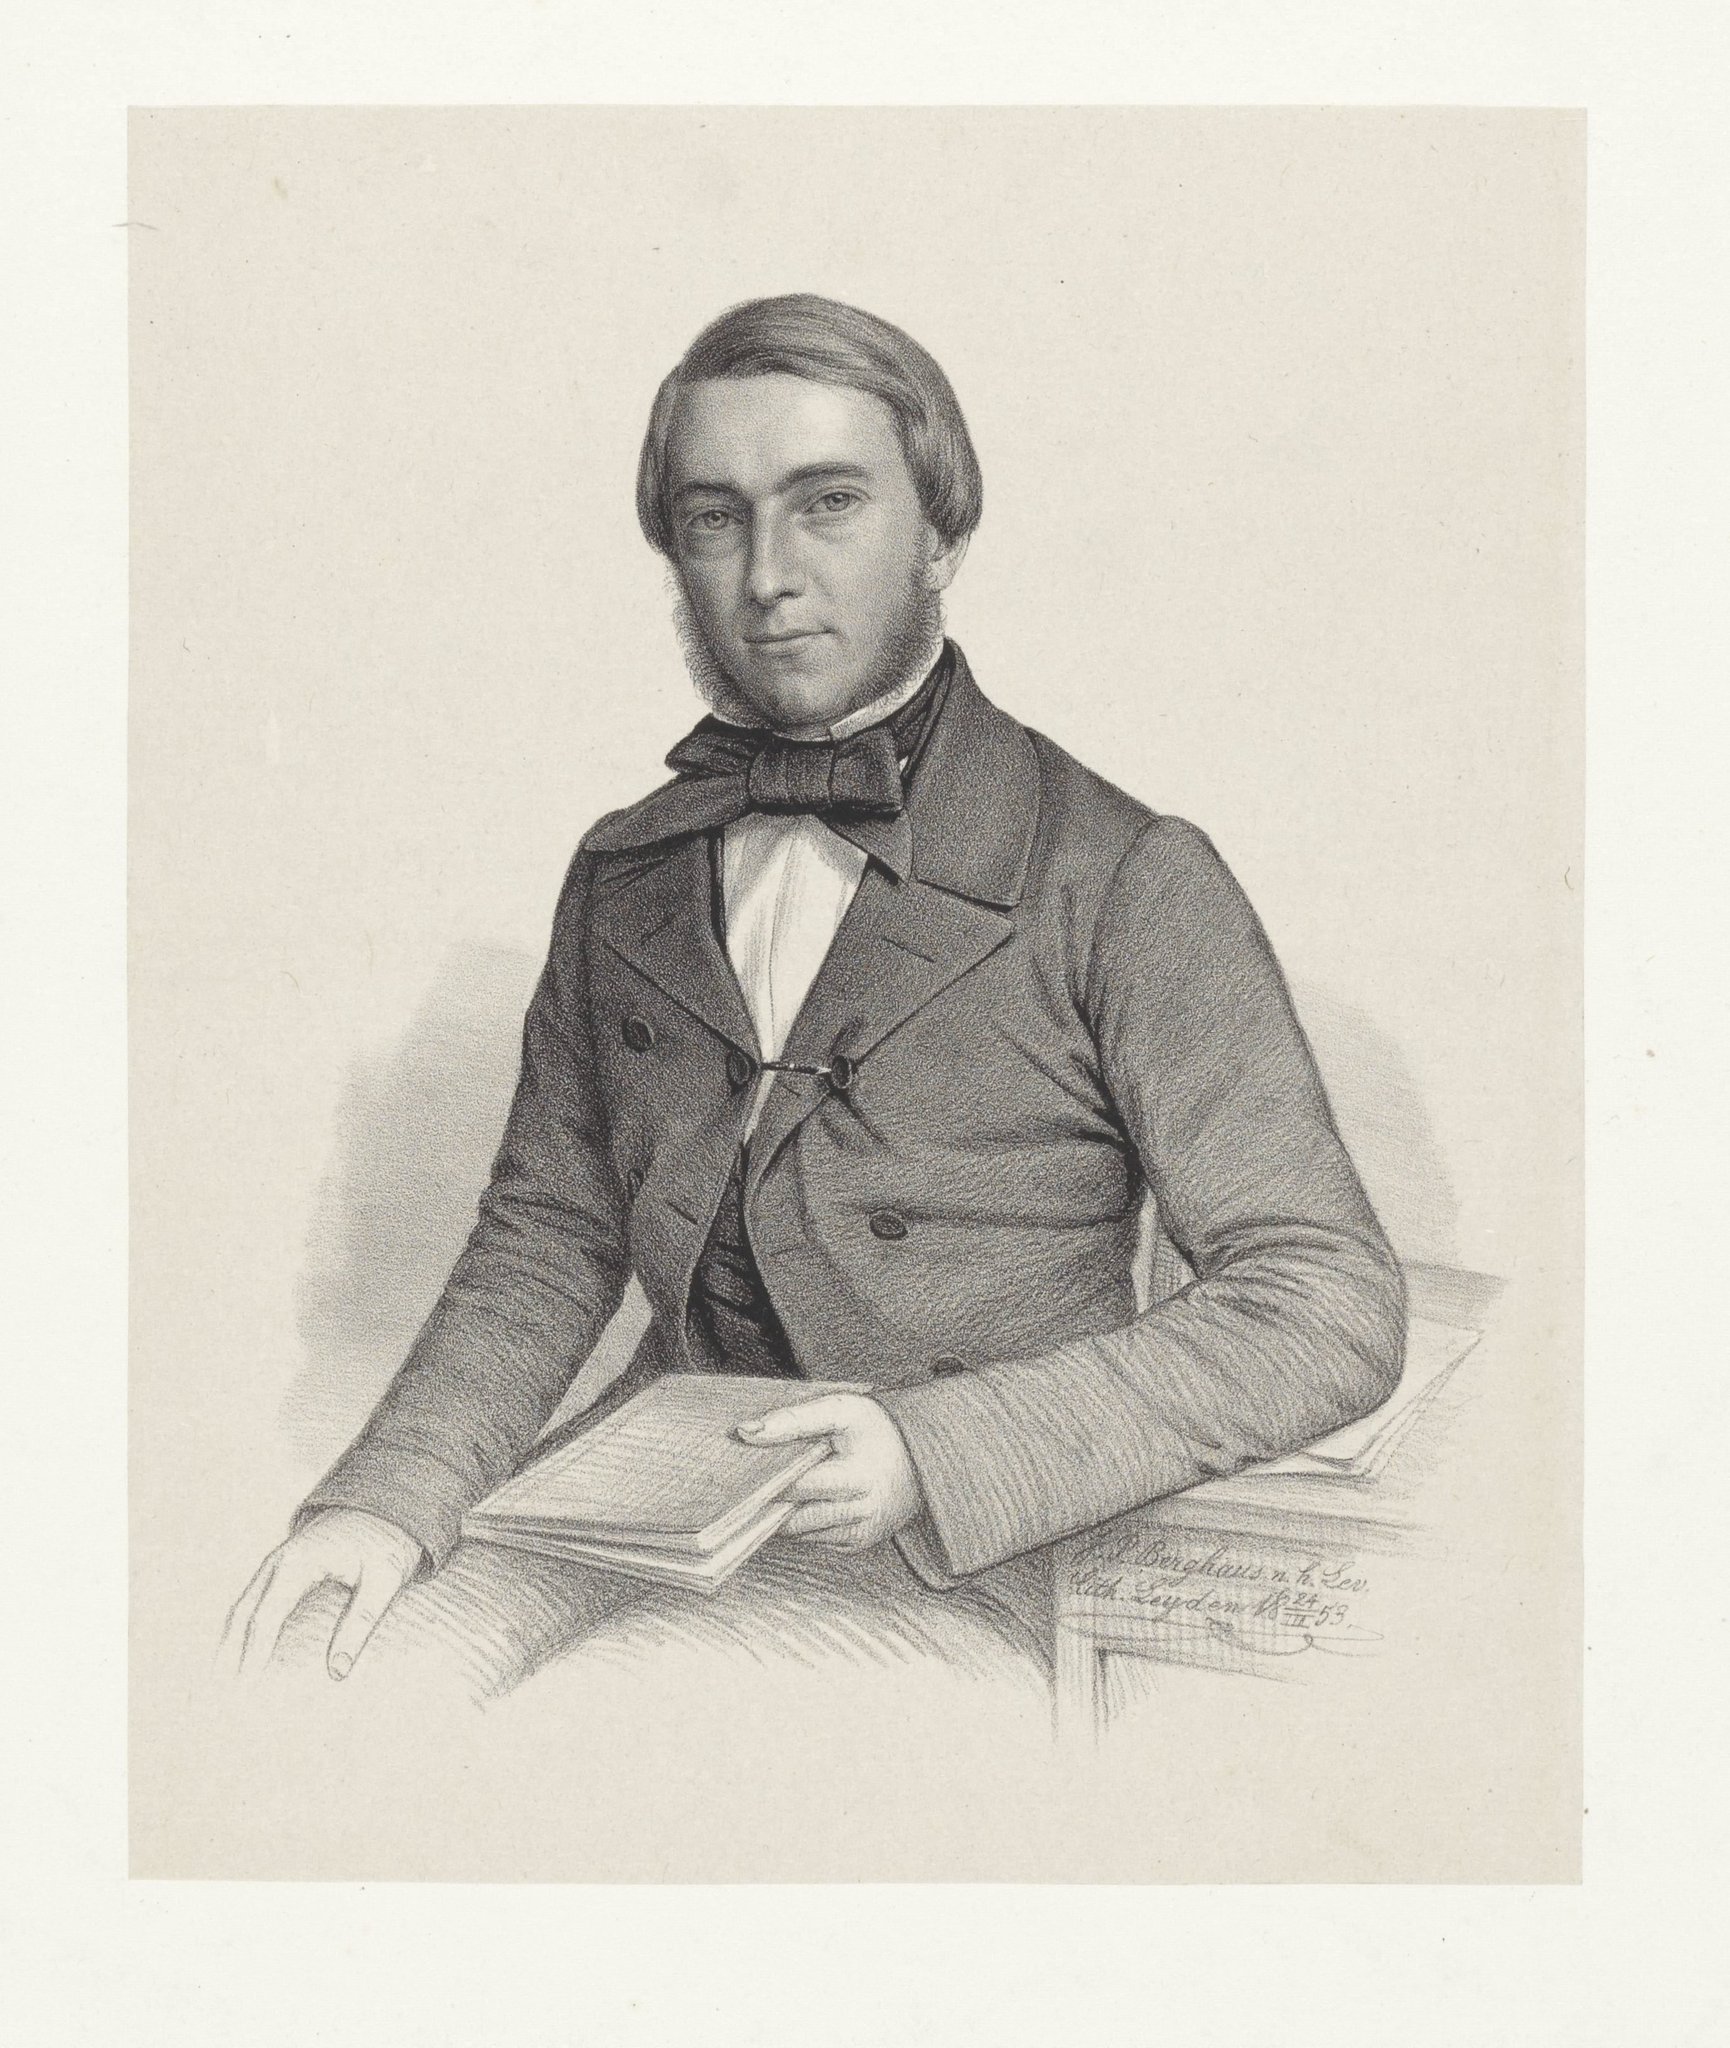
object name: print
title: Portret van I.Z. Herman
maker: johann peter berghaus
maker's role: print maker, printer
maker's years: 1810-1870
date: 1853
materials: paper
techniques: lithograph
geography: leiden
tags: historical persons, fibula, safety pin, book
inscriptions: collector's mark: Lugt 2228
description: De geportretteerde zit naast een tafel. Zijn linkerelleboog rust op de tafel met daarop enkele vellen papier. In zijn linkerhand heeft hij een boek dat in zijn schoot rust. Zijn wijsvinger heeft hij tussen de bladzijden. Hij draagt een speld tussen twee knoopsgaten van zijn jas.